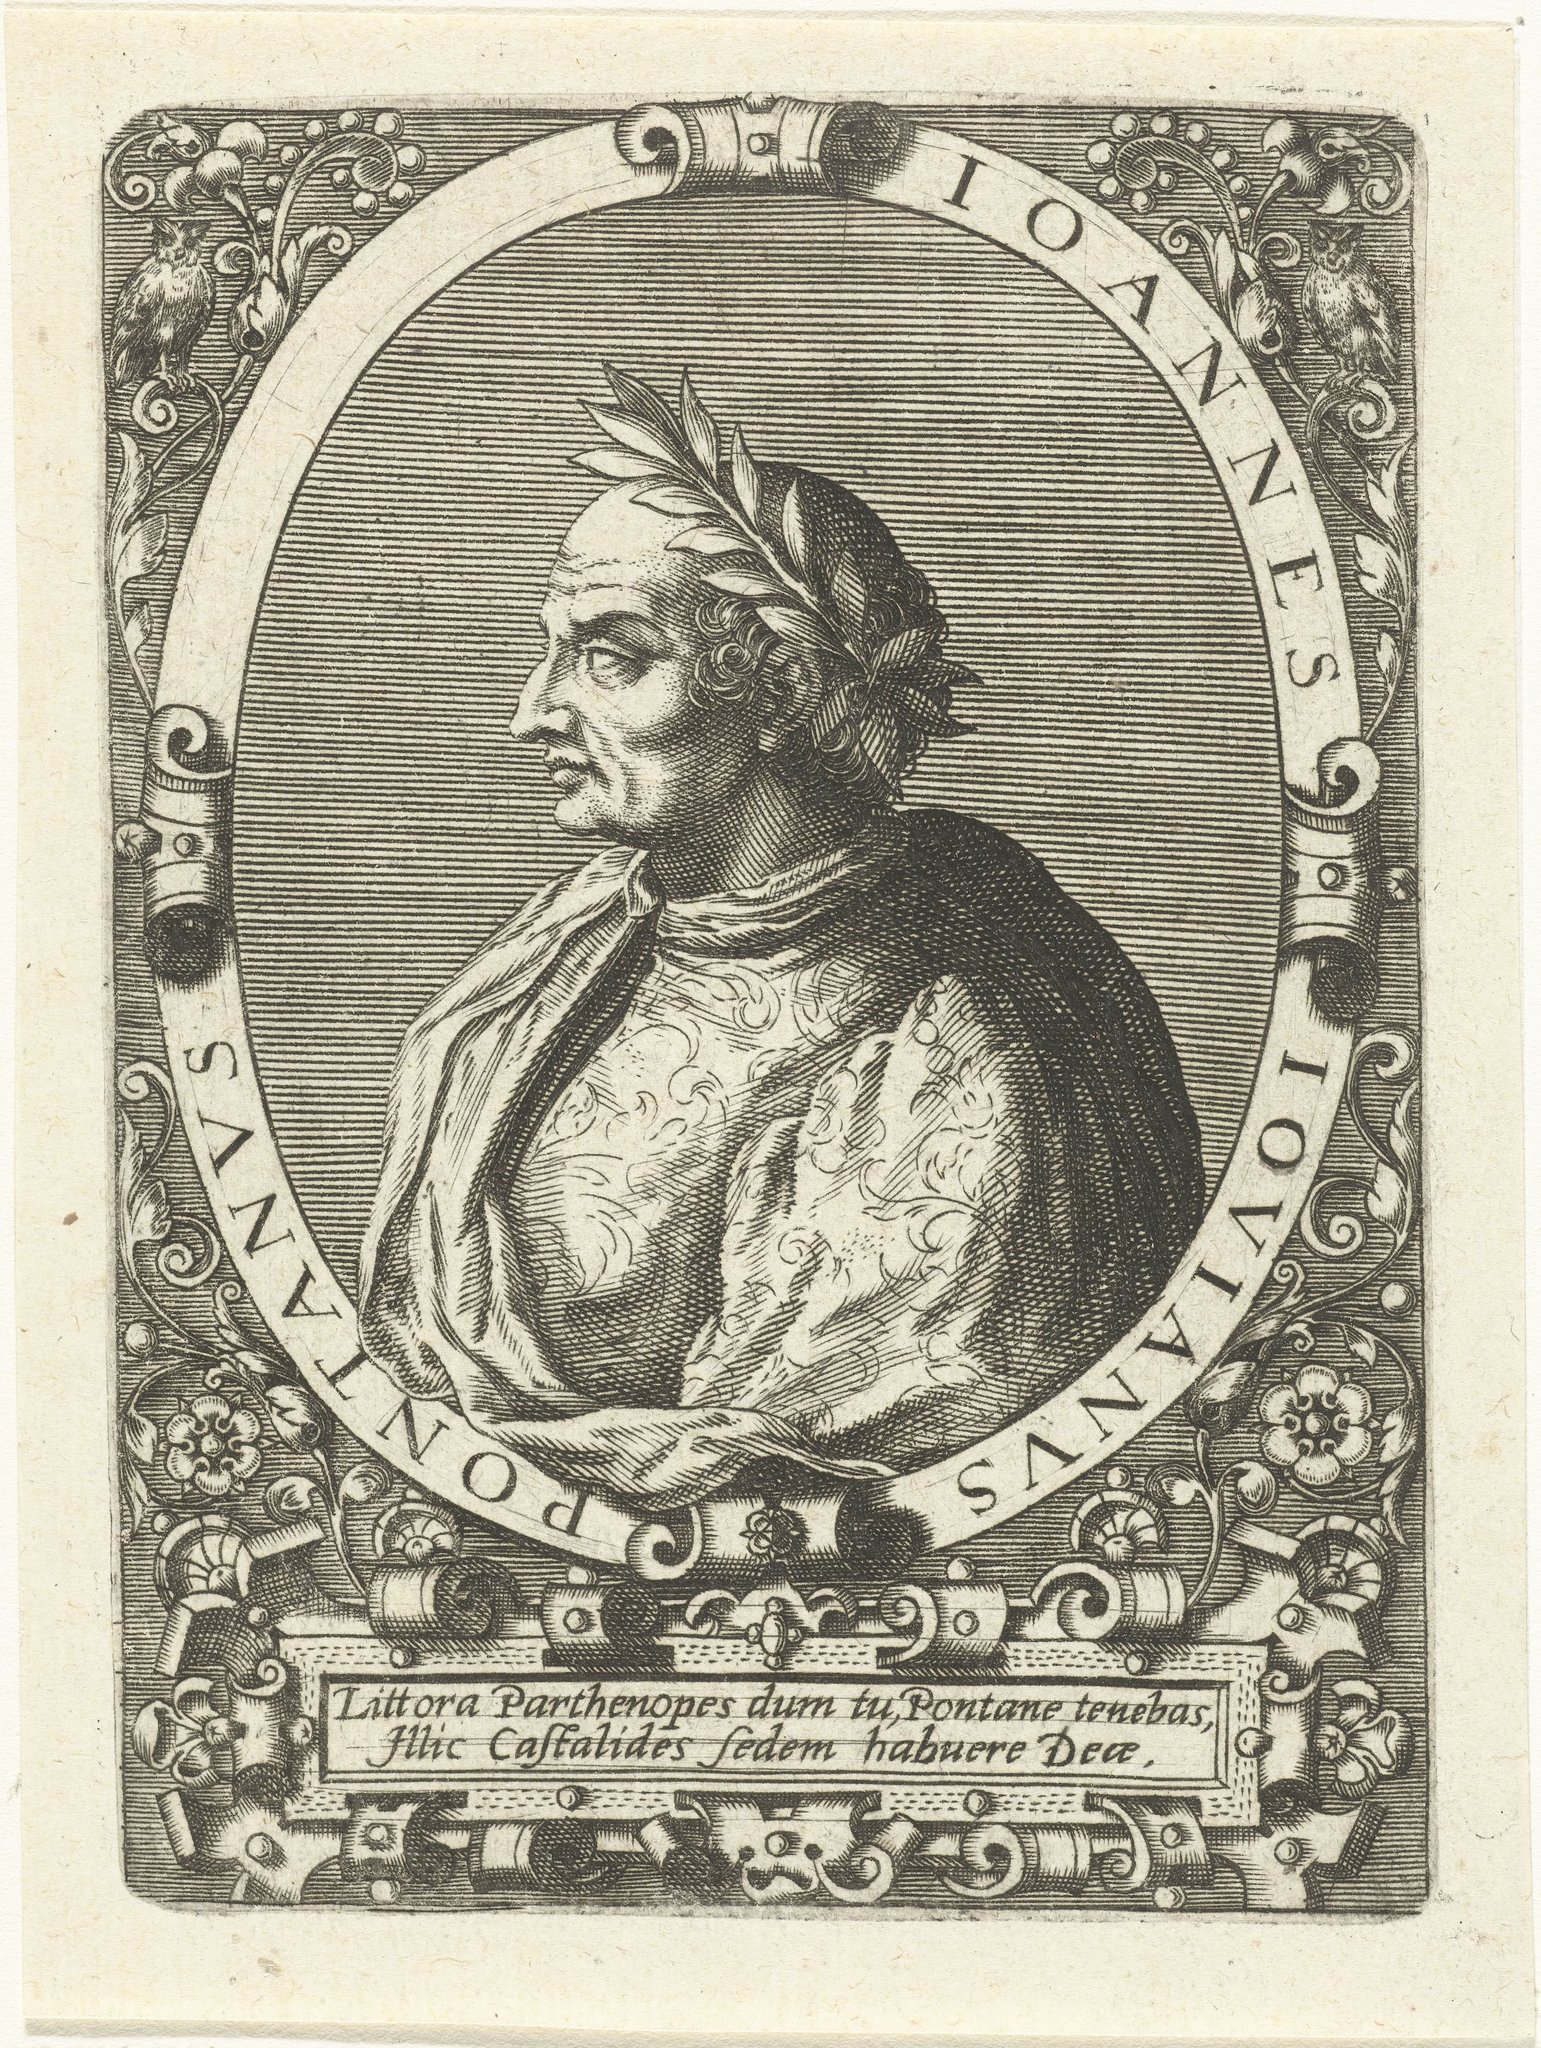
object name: print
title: Ioannes Iovianus Pontanus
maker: jean jacques boissard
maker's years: 1528-1598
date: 1597-1599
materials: paper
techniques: engraving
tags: cerreto di spoleto, schrijver, humanist, giovanni pontano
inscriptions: collector's mark: Lugt 2228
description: Portret van de Italiaanse humanist Giovanni Gioviano Pontano, in ovaal met randschrift. Pontano heeft een lauwerkrans op zijn hoofd. Onder het portret een Latijns vers.